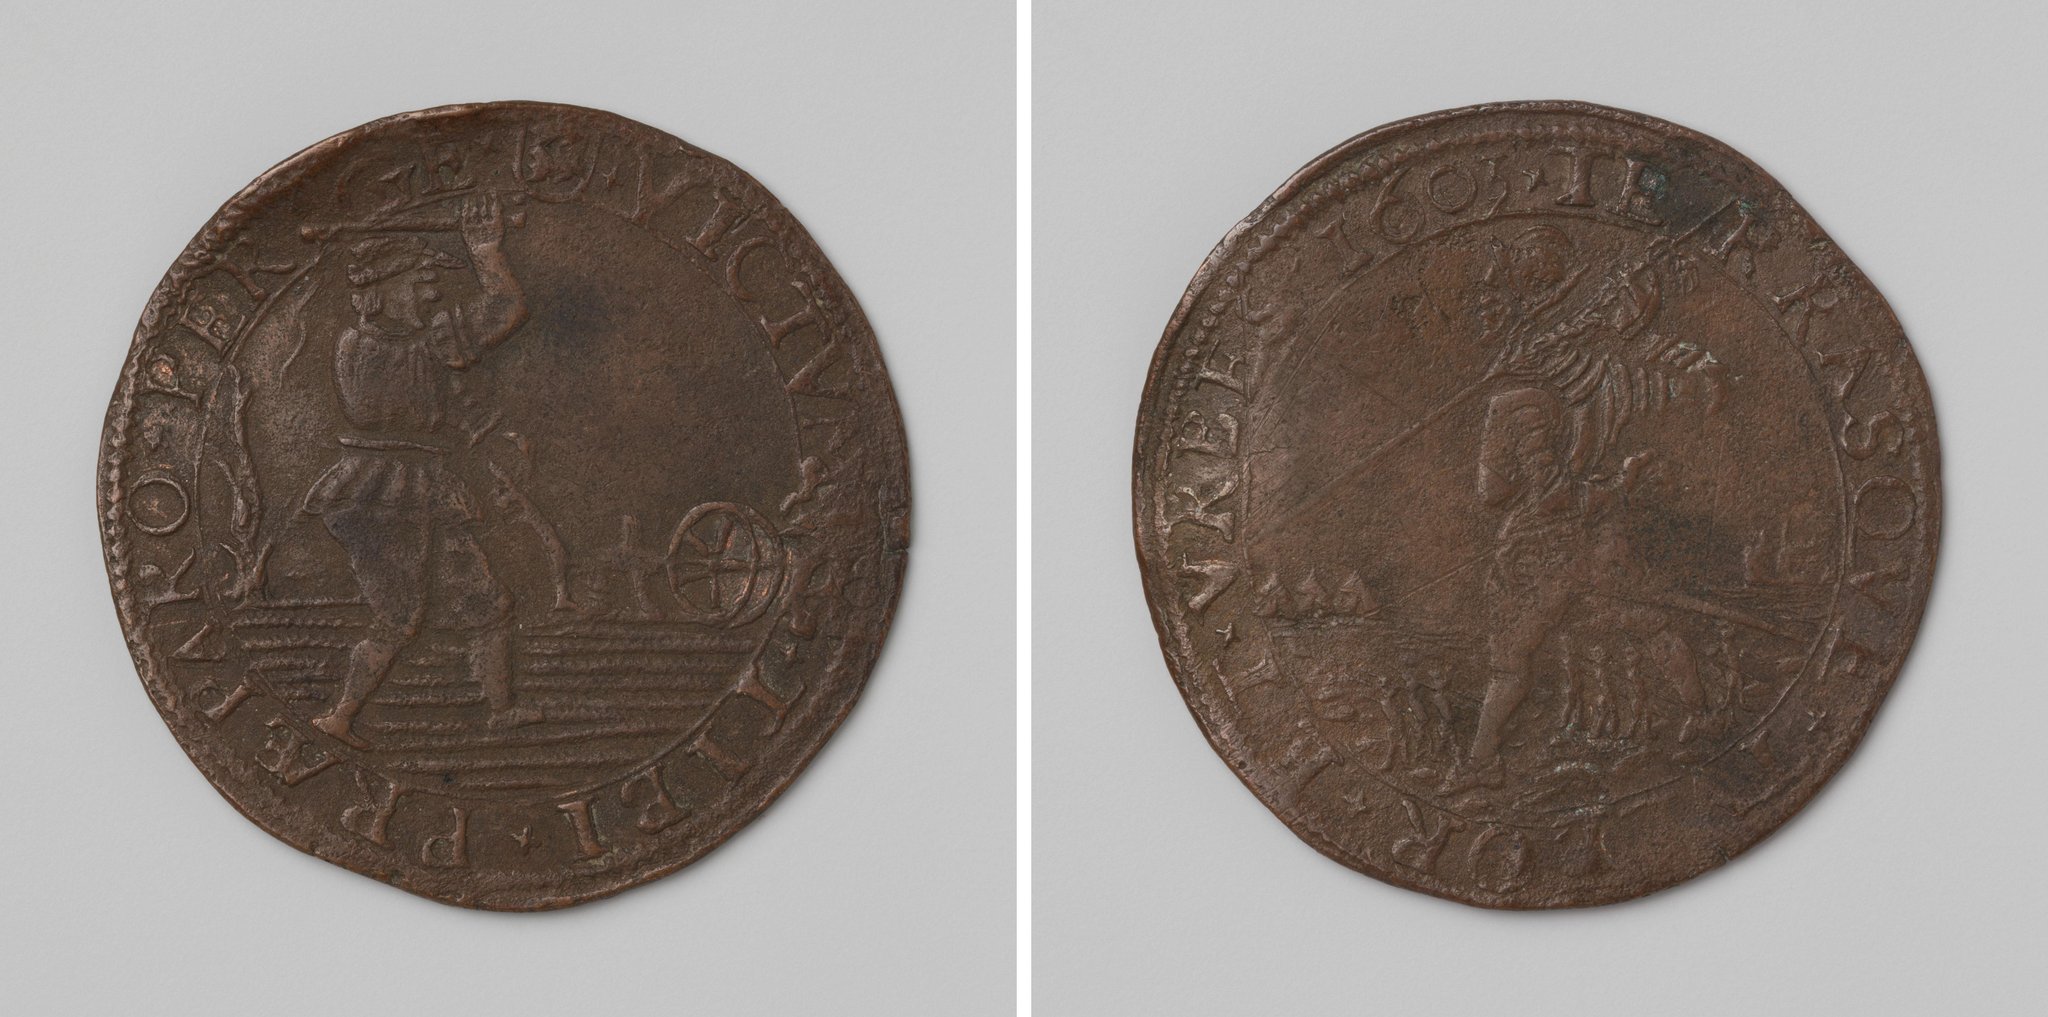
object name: jeton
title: De strijd tegen Spanje bekostigd uit de welvarende economie der Nederlanden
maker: Anonymous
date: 1603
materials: copper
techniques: striking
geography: west frisia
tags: staten van west-friesland, west-friesland, tachtigjarige oorlog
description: Koperen penning. Voorzijde: ploegende boer met zweep boven hoofd binnen omschrift. Keerzijde: gehelmde soldaat met speer in hand; op achtergrond marcherende troepen binnen omschrift